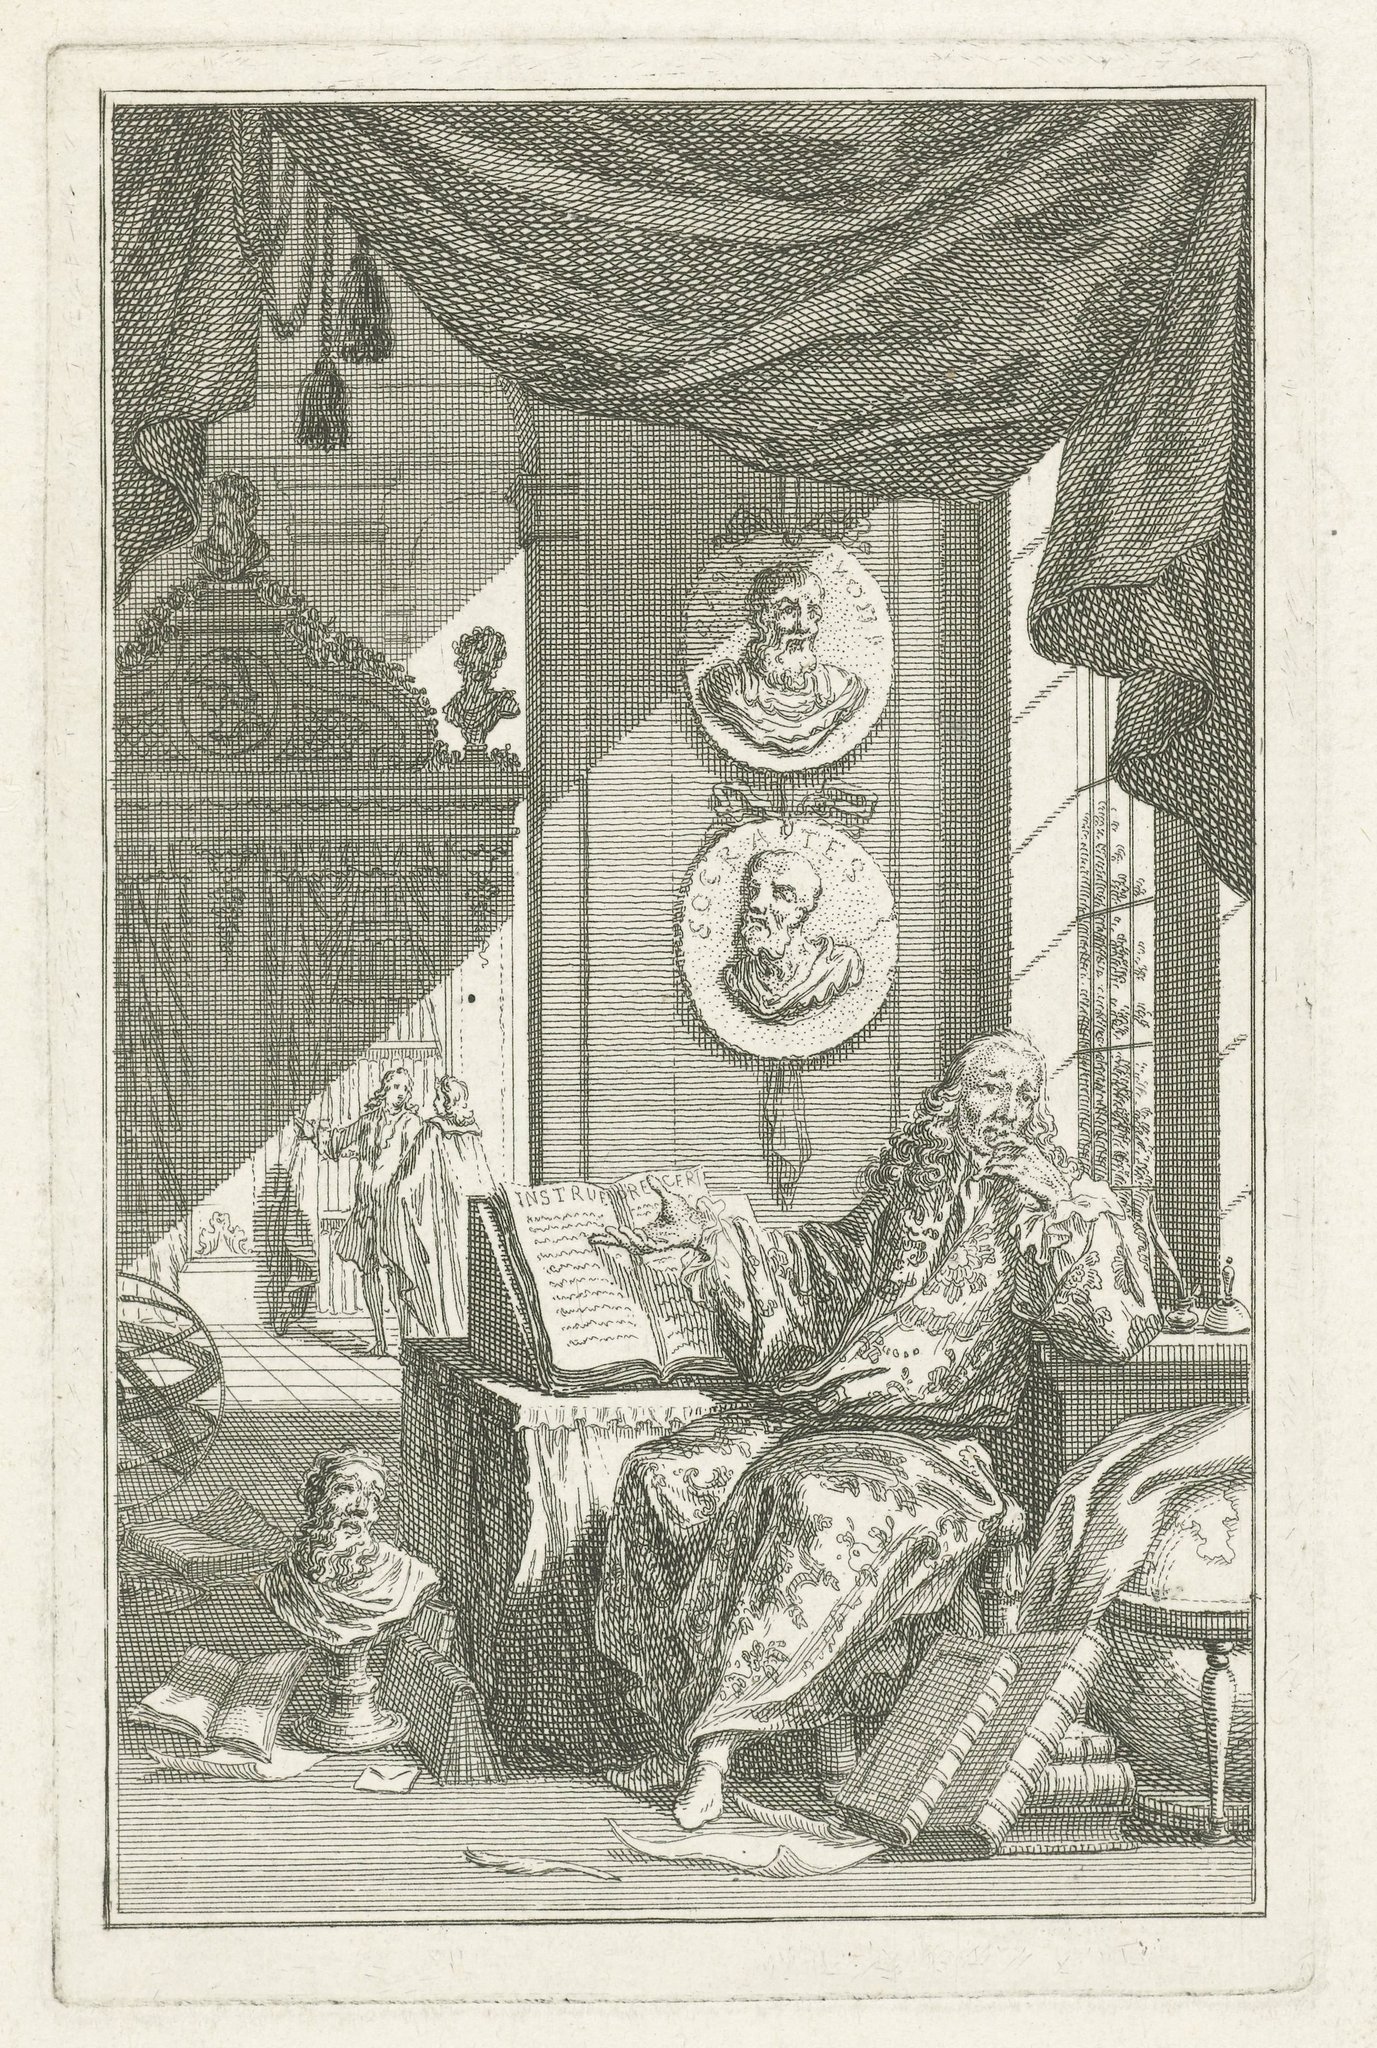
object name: print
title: Geleerde in studeervertrek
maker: simon fokke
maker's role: draughtsman, print maker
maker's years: 1712-1784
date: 1759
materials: paper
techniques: etching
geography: amsterdam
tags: scholar in his study, study; 'studiolo'; library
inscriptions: collector's mark: Lugt 2228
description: Een geleerde zit achter een bureau in een studeervertrek en wijst op een opengeslagen boek. Boven zijn bureau hangen twee medaillons met de beeltenissen van filosofen uit de Oudheid. Op de grond rond zijn bureau liggen papieren en boeken en staan een portretbuste en een wereldbol.